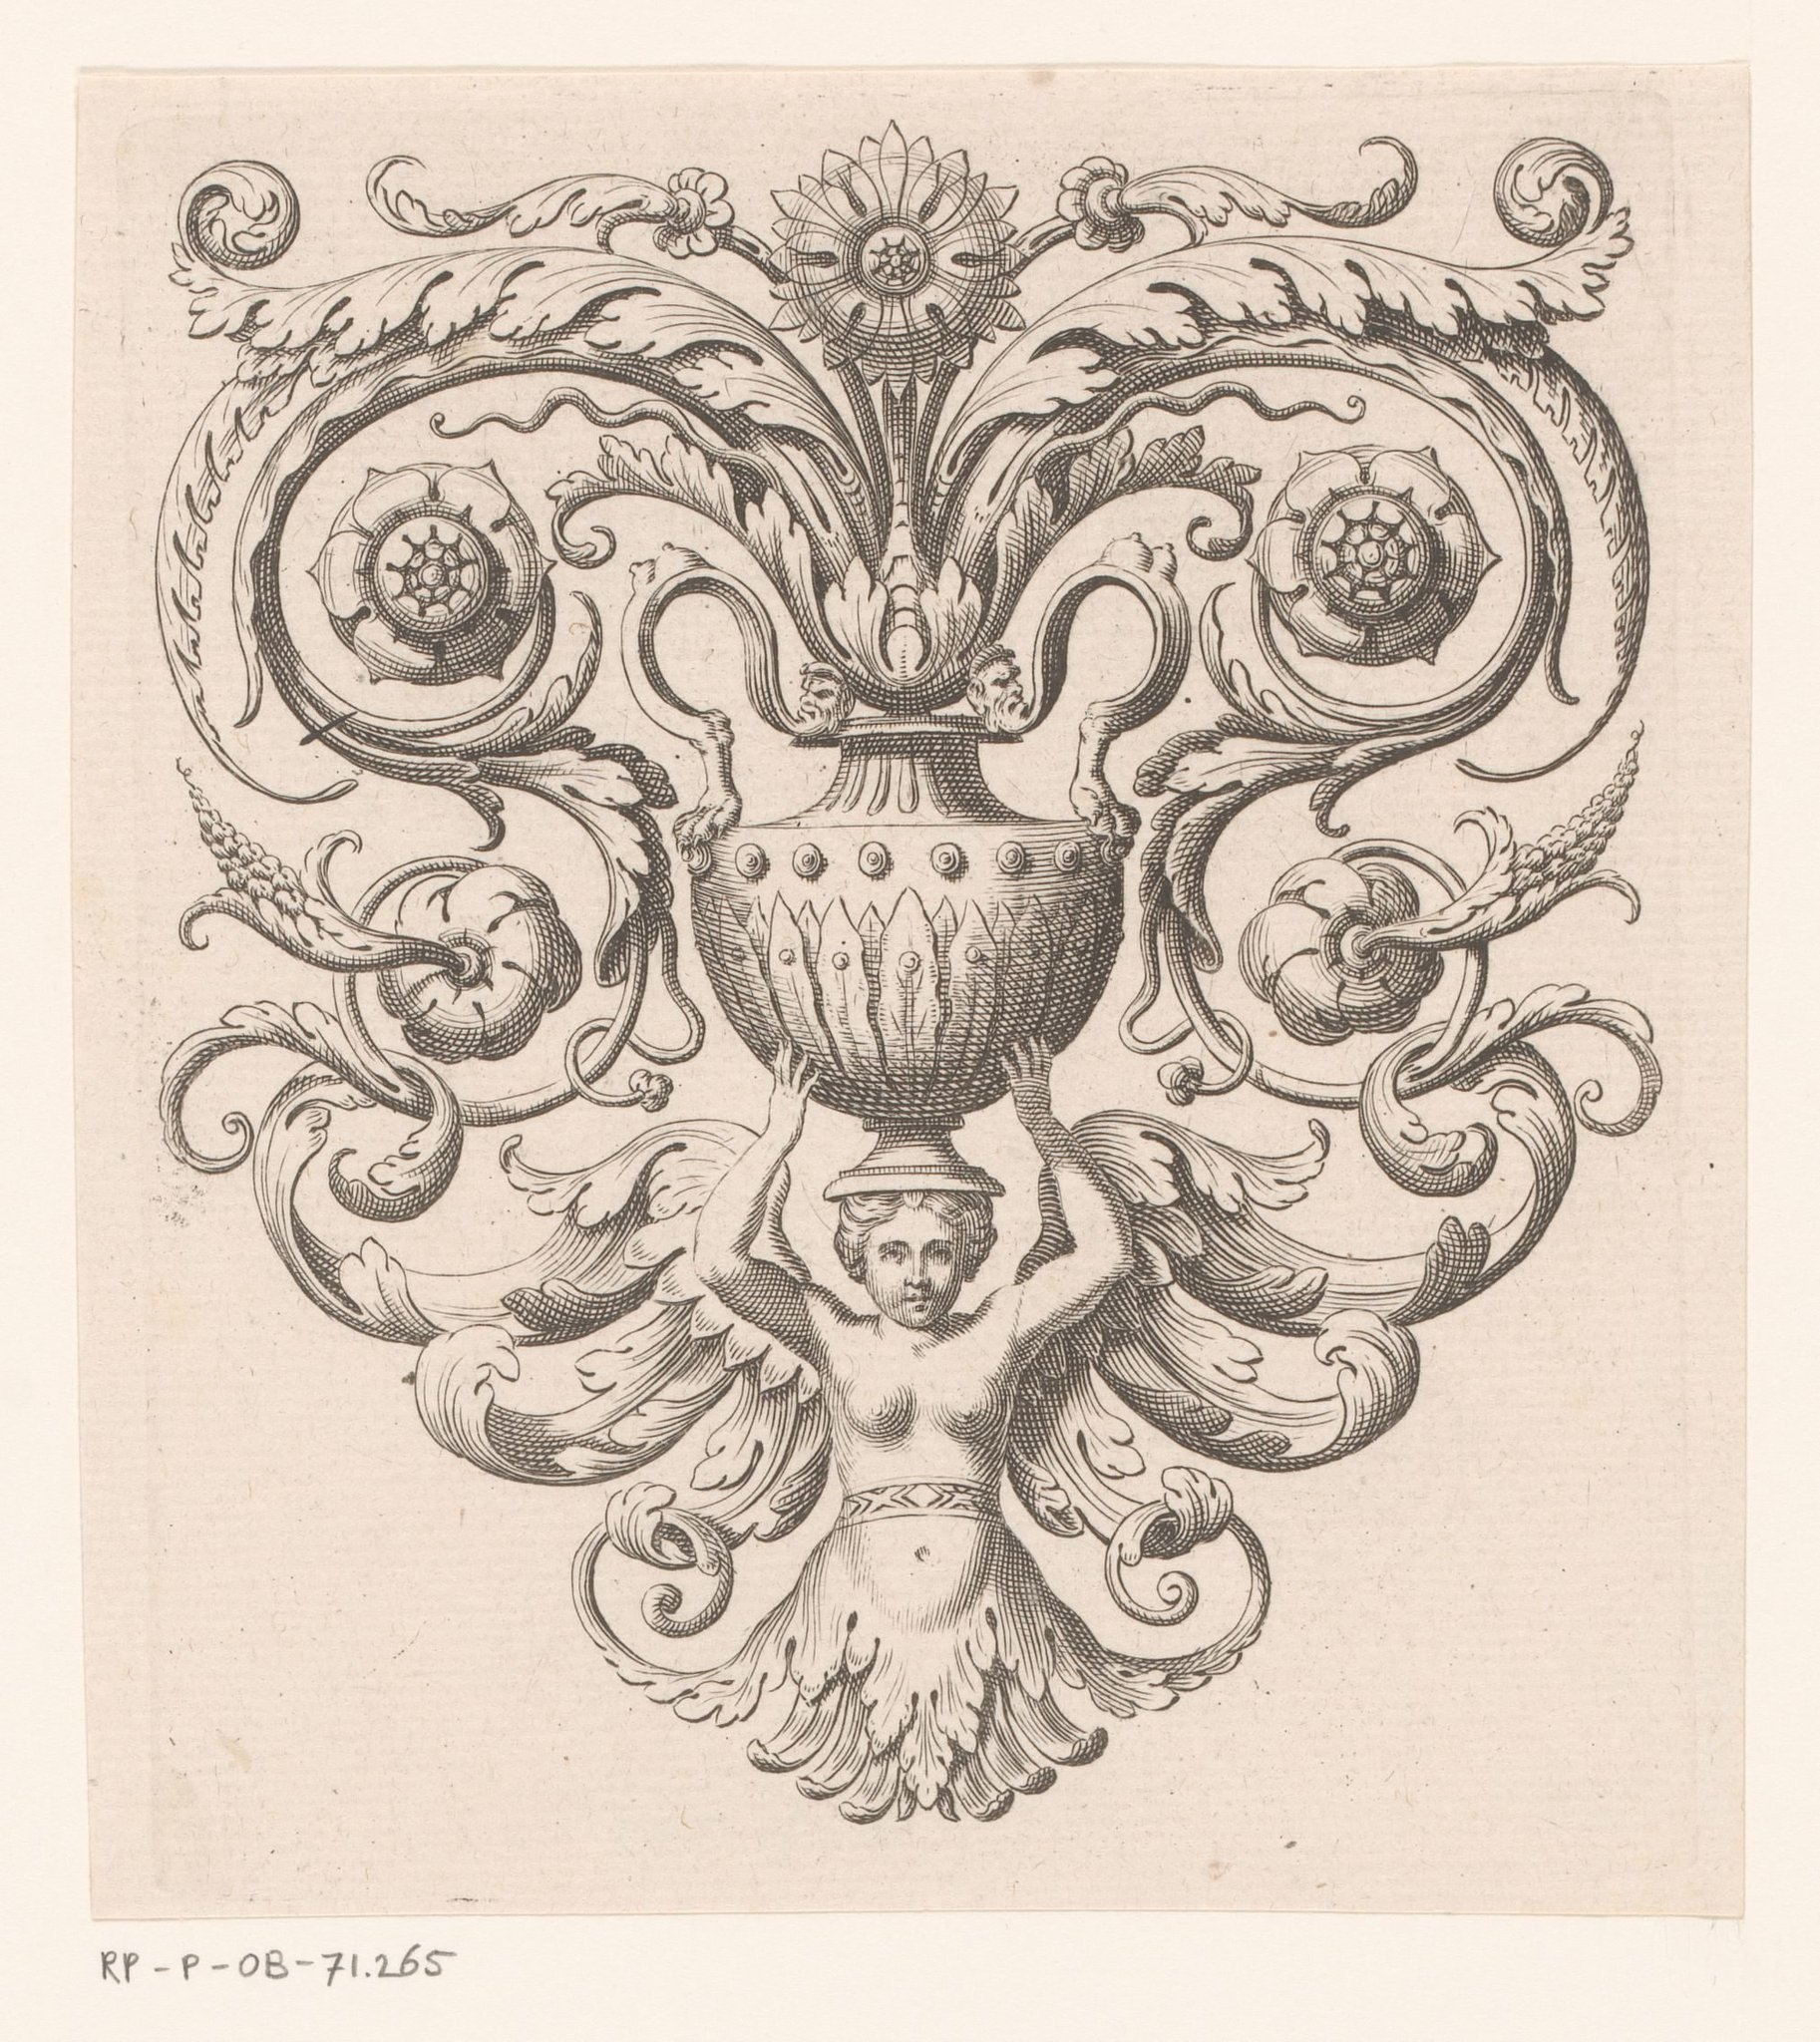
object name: print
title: Cul-de-lampe met een vrouw met een vaas op haar hoofd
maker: claude mellan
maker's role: draughtsman, print maker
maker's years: 1598-1688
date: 1608-1688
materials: paper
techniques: engraving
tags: decoration of printed matter, vase ~ ornament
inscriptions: collector's mark: Lugt 240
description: Mogelijk vervaardigde Mellan deze prent in samenwerking met de Imprimerie Royale. Tussen 1639-1643 werkte Mellan samen met de Imprimerie Royale (IFF 17e siècle, p. 21-22). Hij vervaardigde verschillende vignetten, letters, culs-de-lampe en decoratieve banden (IFF 17e siècle, p. 215-220).